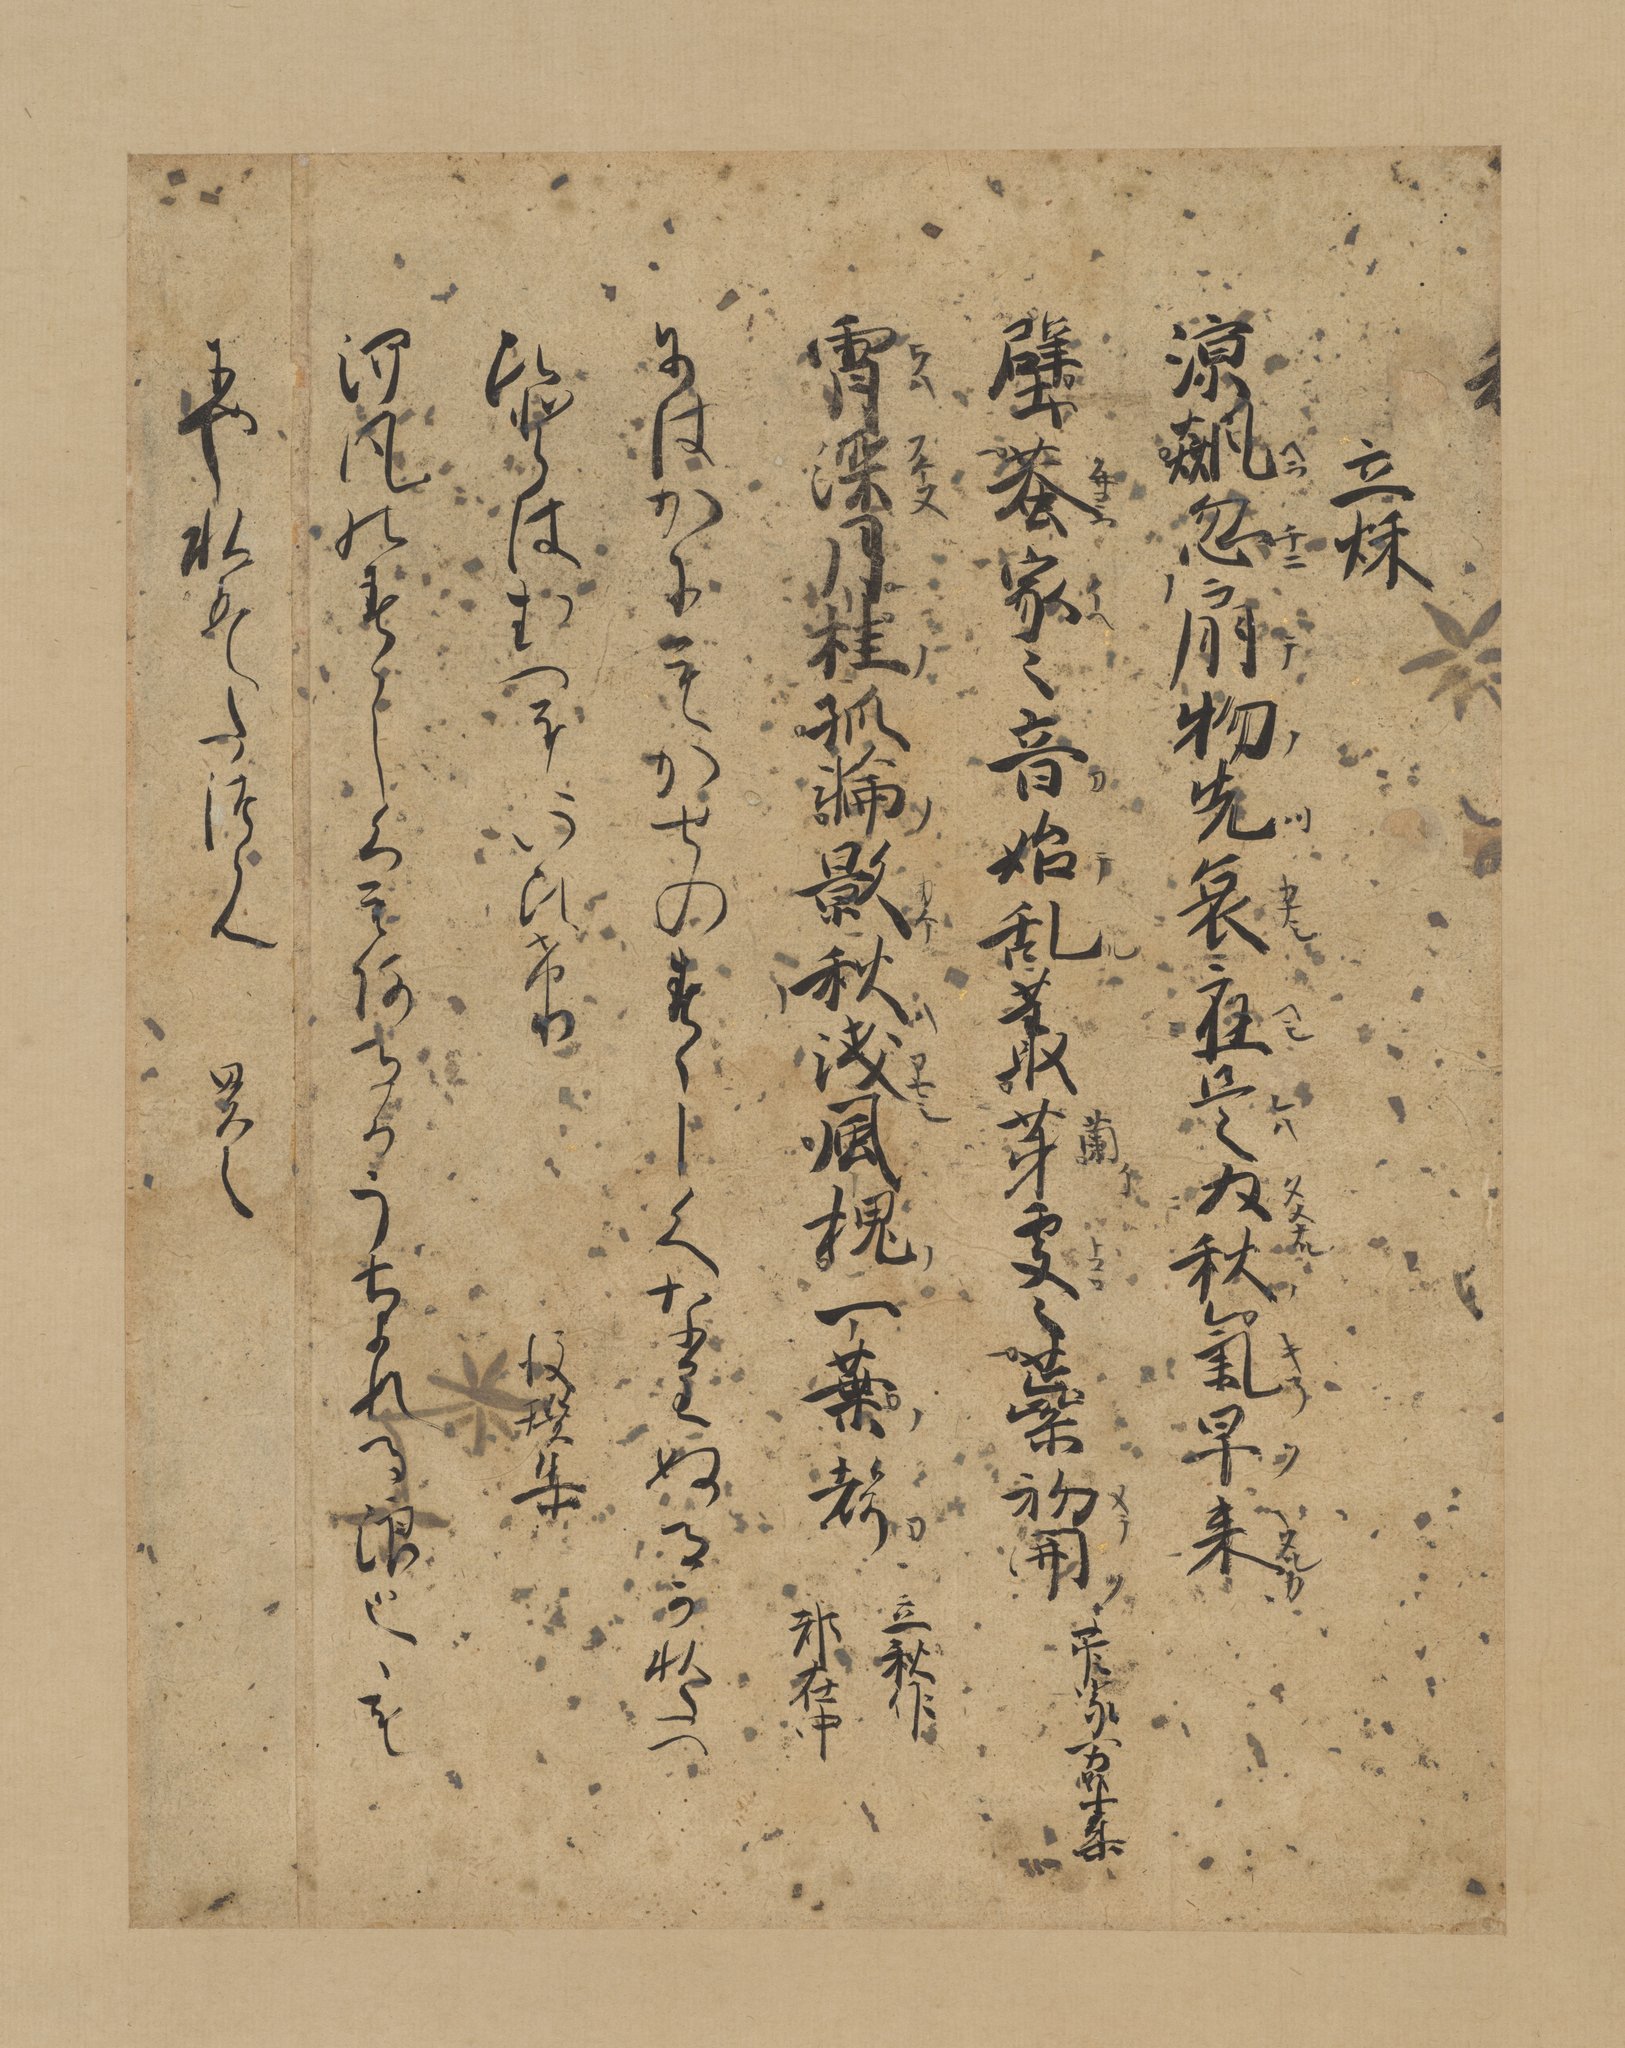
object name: hanging scroll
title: Poems about the Arrival of Autumn, from Newly Selected Collection of Poems to Sing (Shinsen rōeishū), one of the “Yamana Fragments” (Yamana-gire)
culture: japanese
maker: fujiwara no mototoshi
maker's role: artist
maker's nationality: japanese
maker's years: 1064-1142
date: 1116-1122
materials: gold, ink, paper, silver